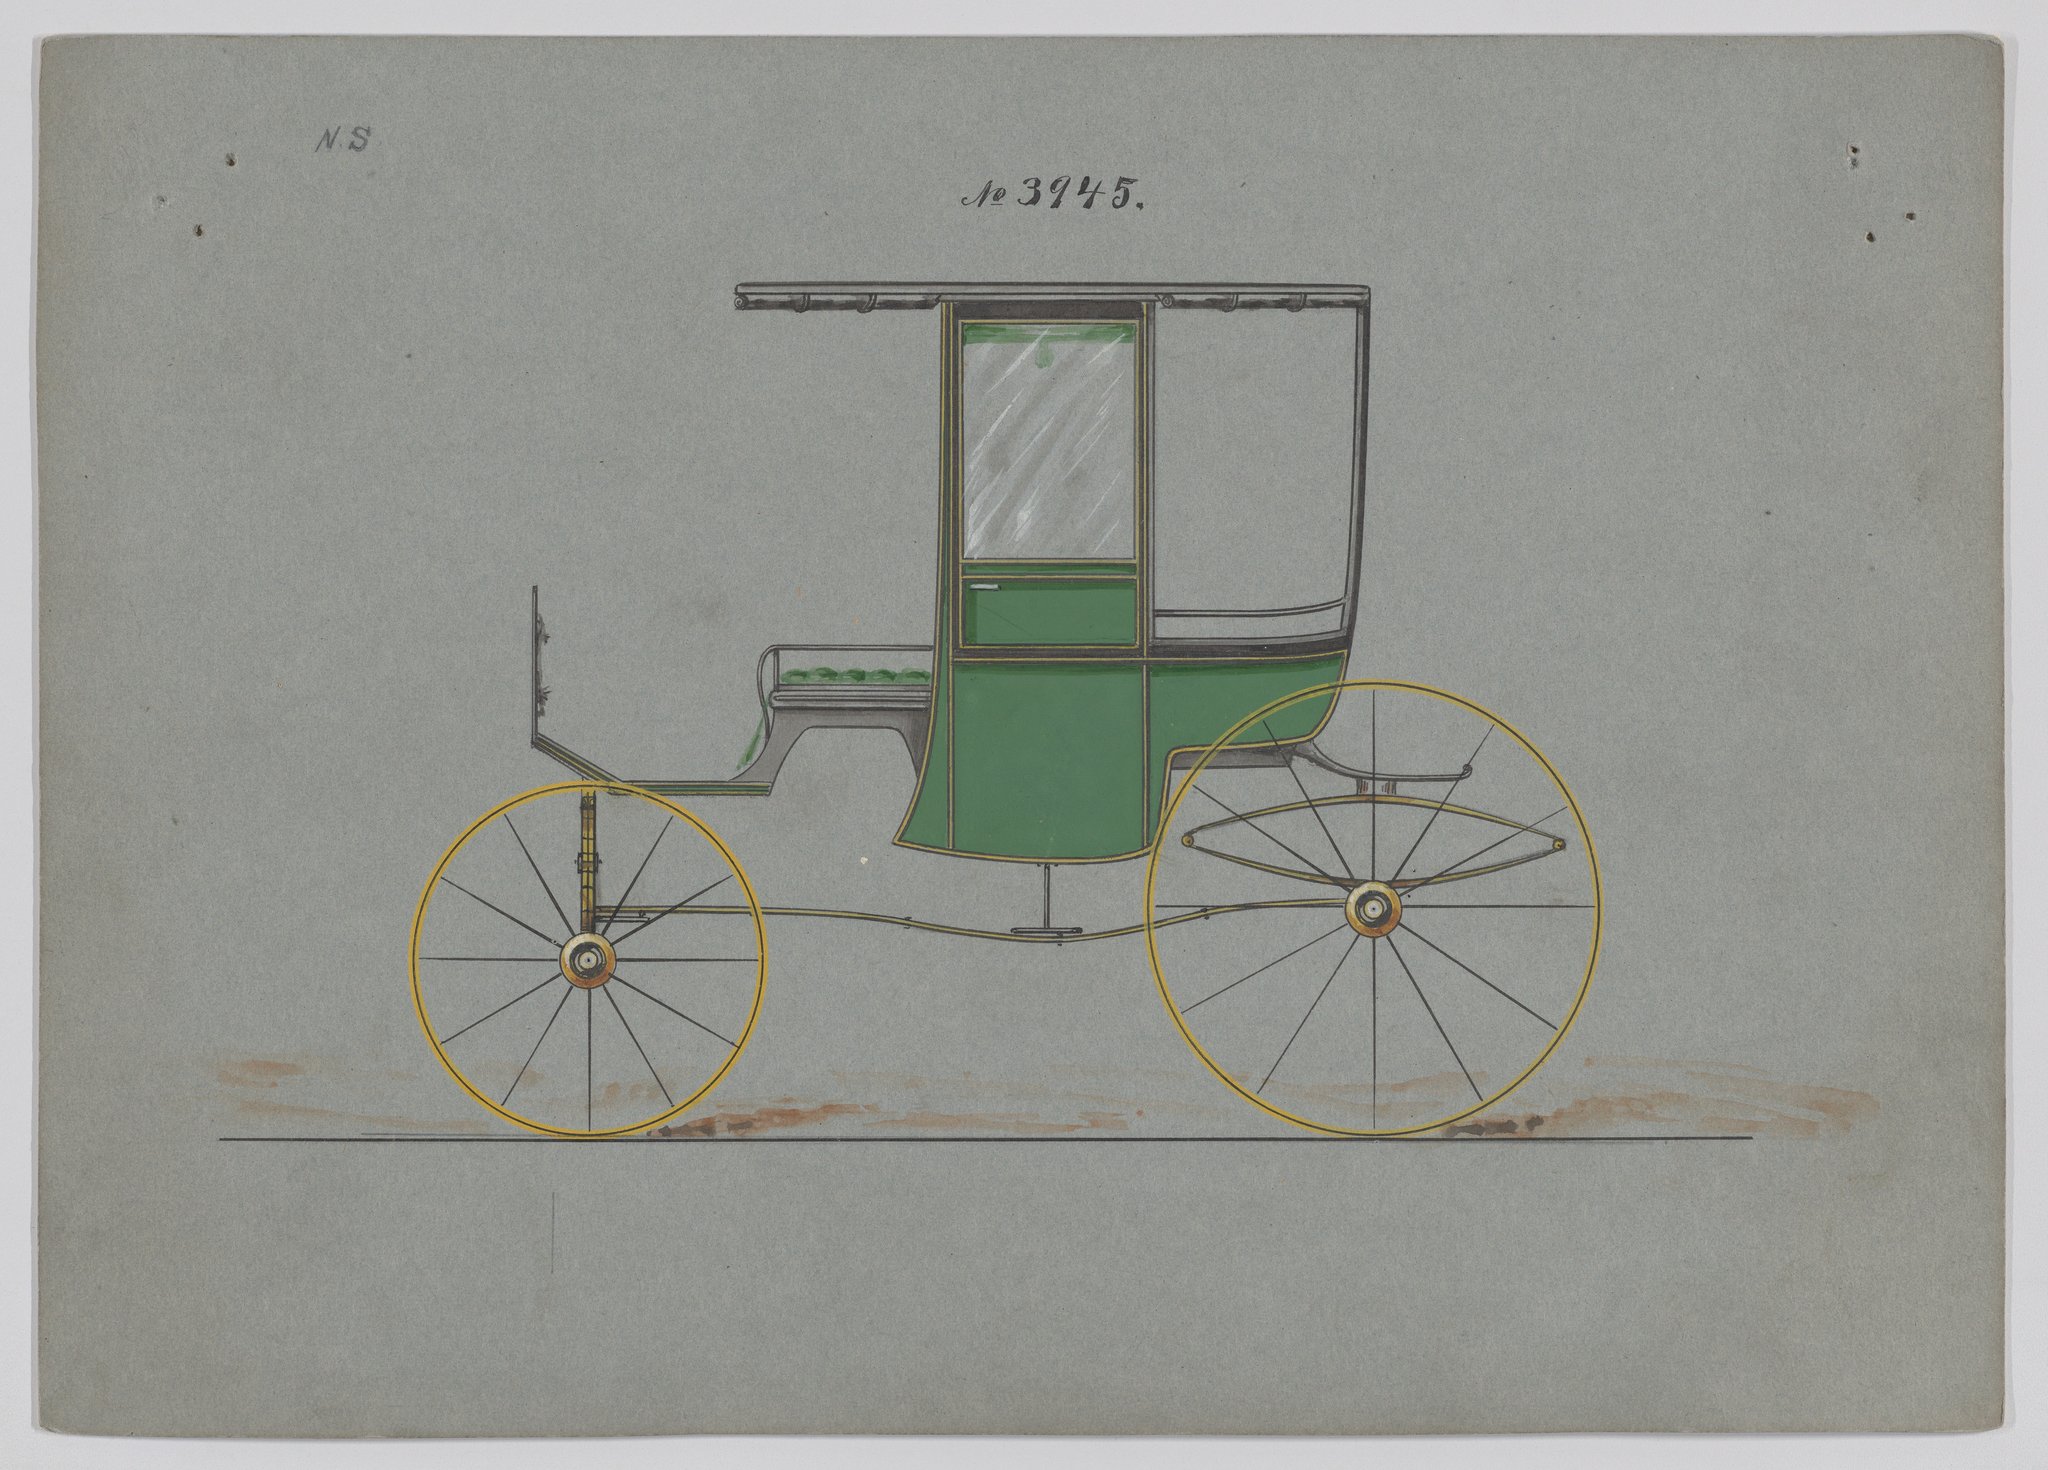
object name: drawing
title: Design for 4 seat Rockaway, no. 3945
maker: brewster & co.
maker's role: manufacturer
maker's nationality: american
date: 1885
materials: gouache, gum arabic, ink, watercolor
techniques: pen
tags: carriages